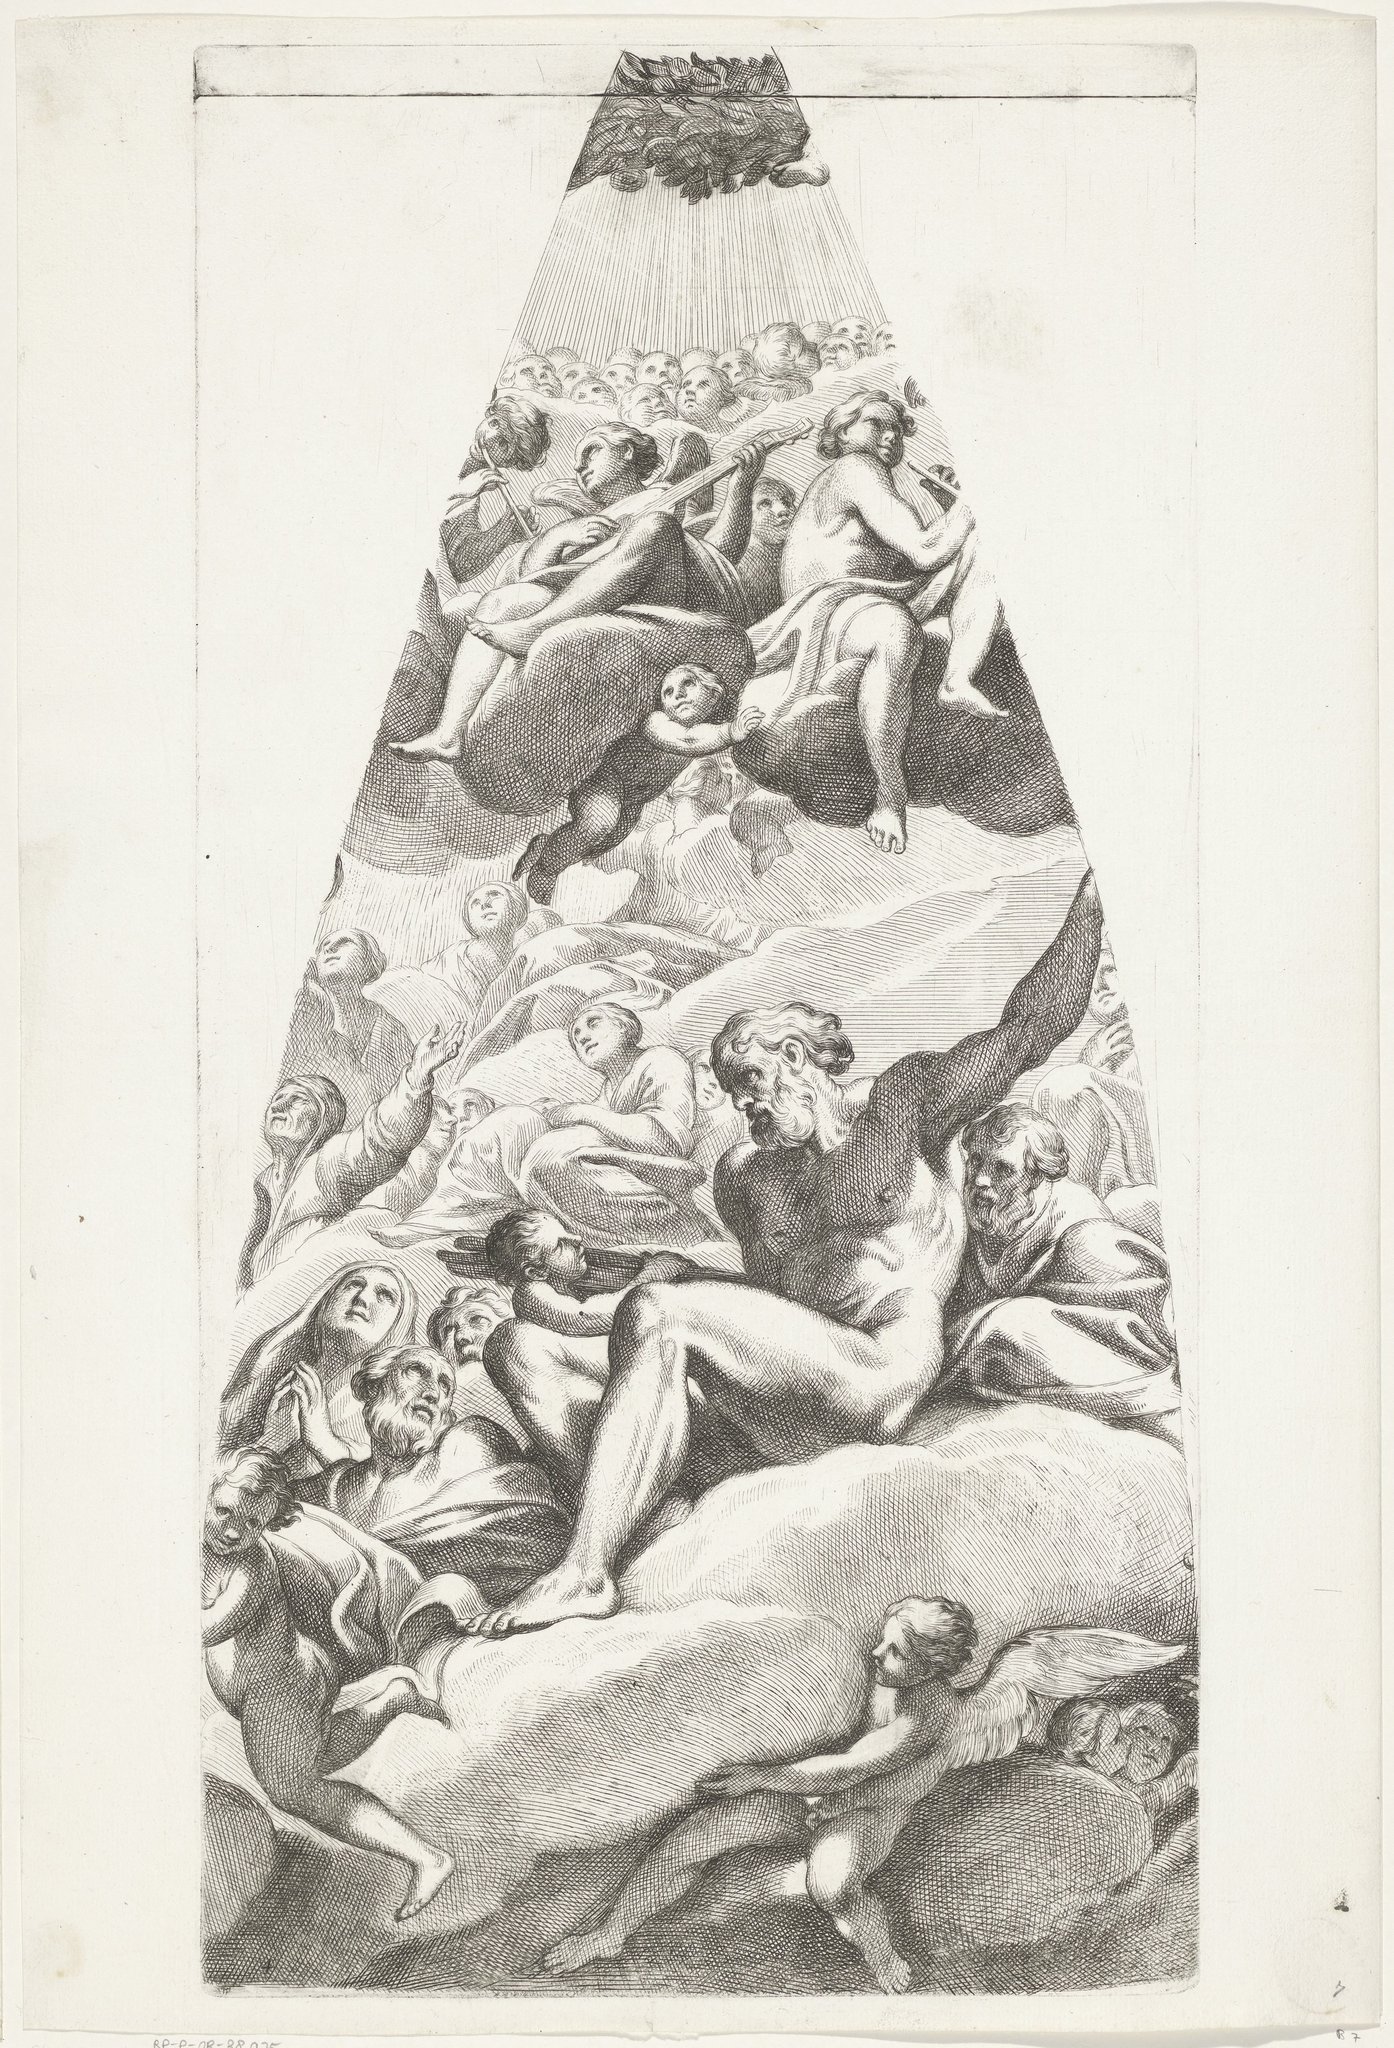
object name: print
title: Hemelvaart van Maria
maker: carlo cesio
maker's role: painter, print maker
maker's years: 1622-1682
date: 1636-1686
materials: paper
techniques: engraving, etching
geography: italy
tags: angels singing, making music, saints, story of isaac, abraham (not in biblical context); possible attribute: knife, angels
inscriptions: collector's mark: Lugt 240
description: Prent uit een reeks van 8 prenten naar de fresco's door Giovanni Lanfranco in de koepel van de San Andrea della Valle te Rome.